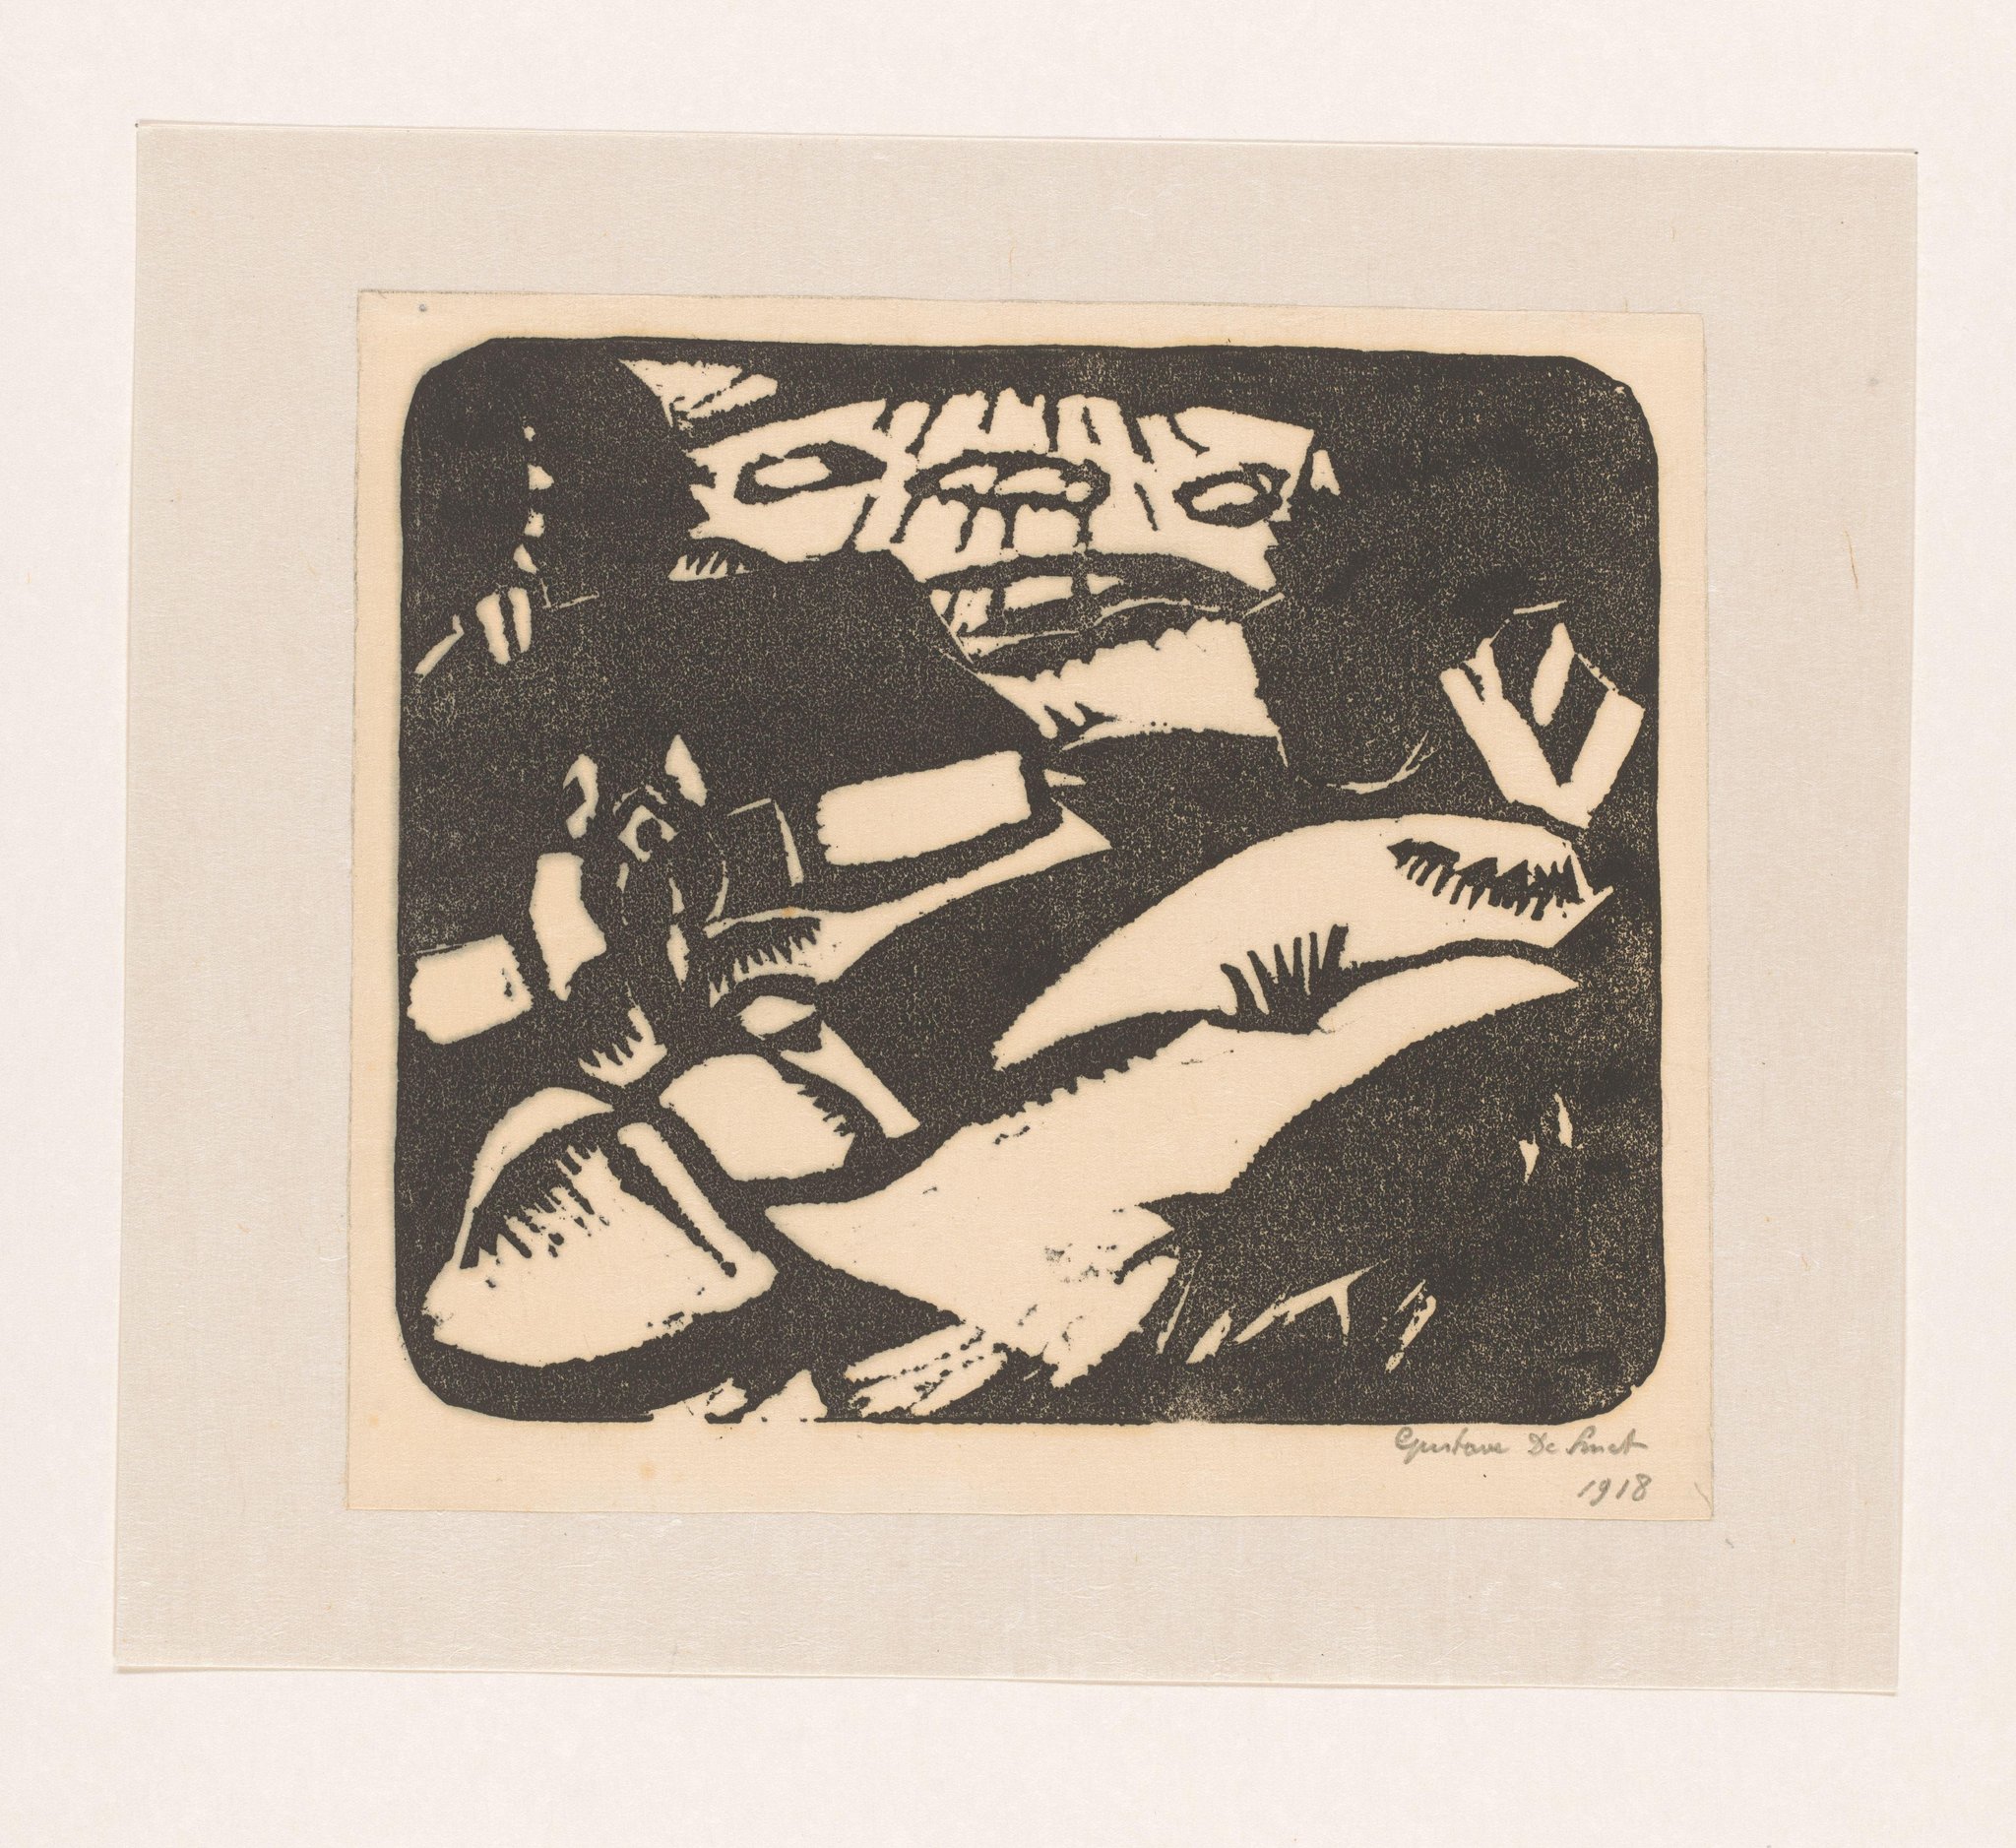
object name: print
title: Veld en huis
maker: gustave de smet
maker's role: print maker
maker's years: 1877-1943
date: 1918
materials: paper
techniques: woodcut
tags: rural housing, e.g. country-house, villa, cottage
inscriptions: collector's mark: Lugt 2228